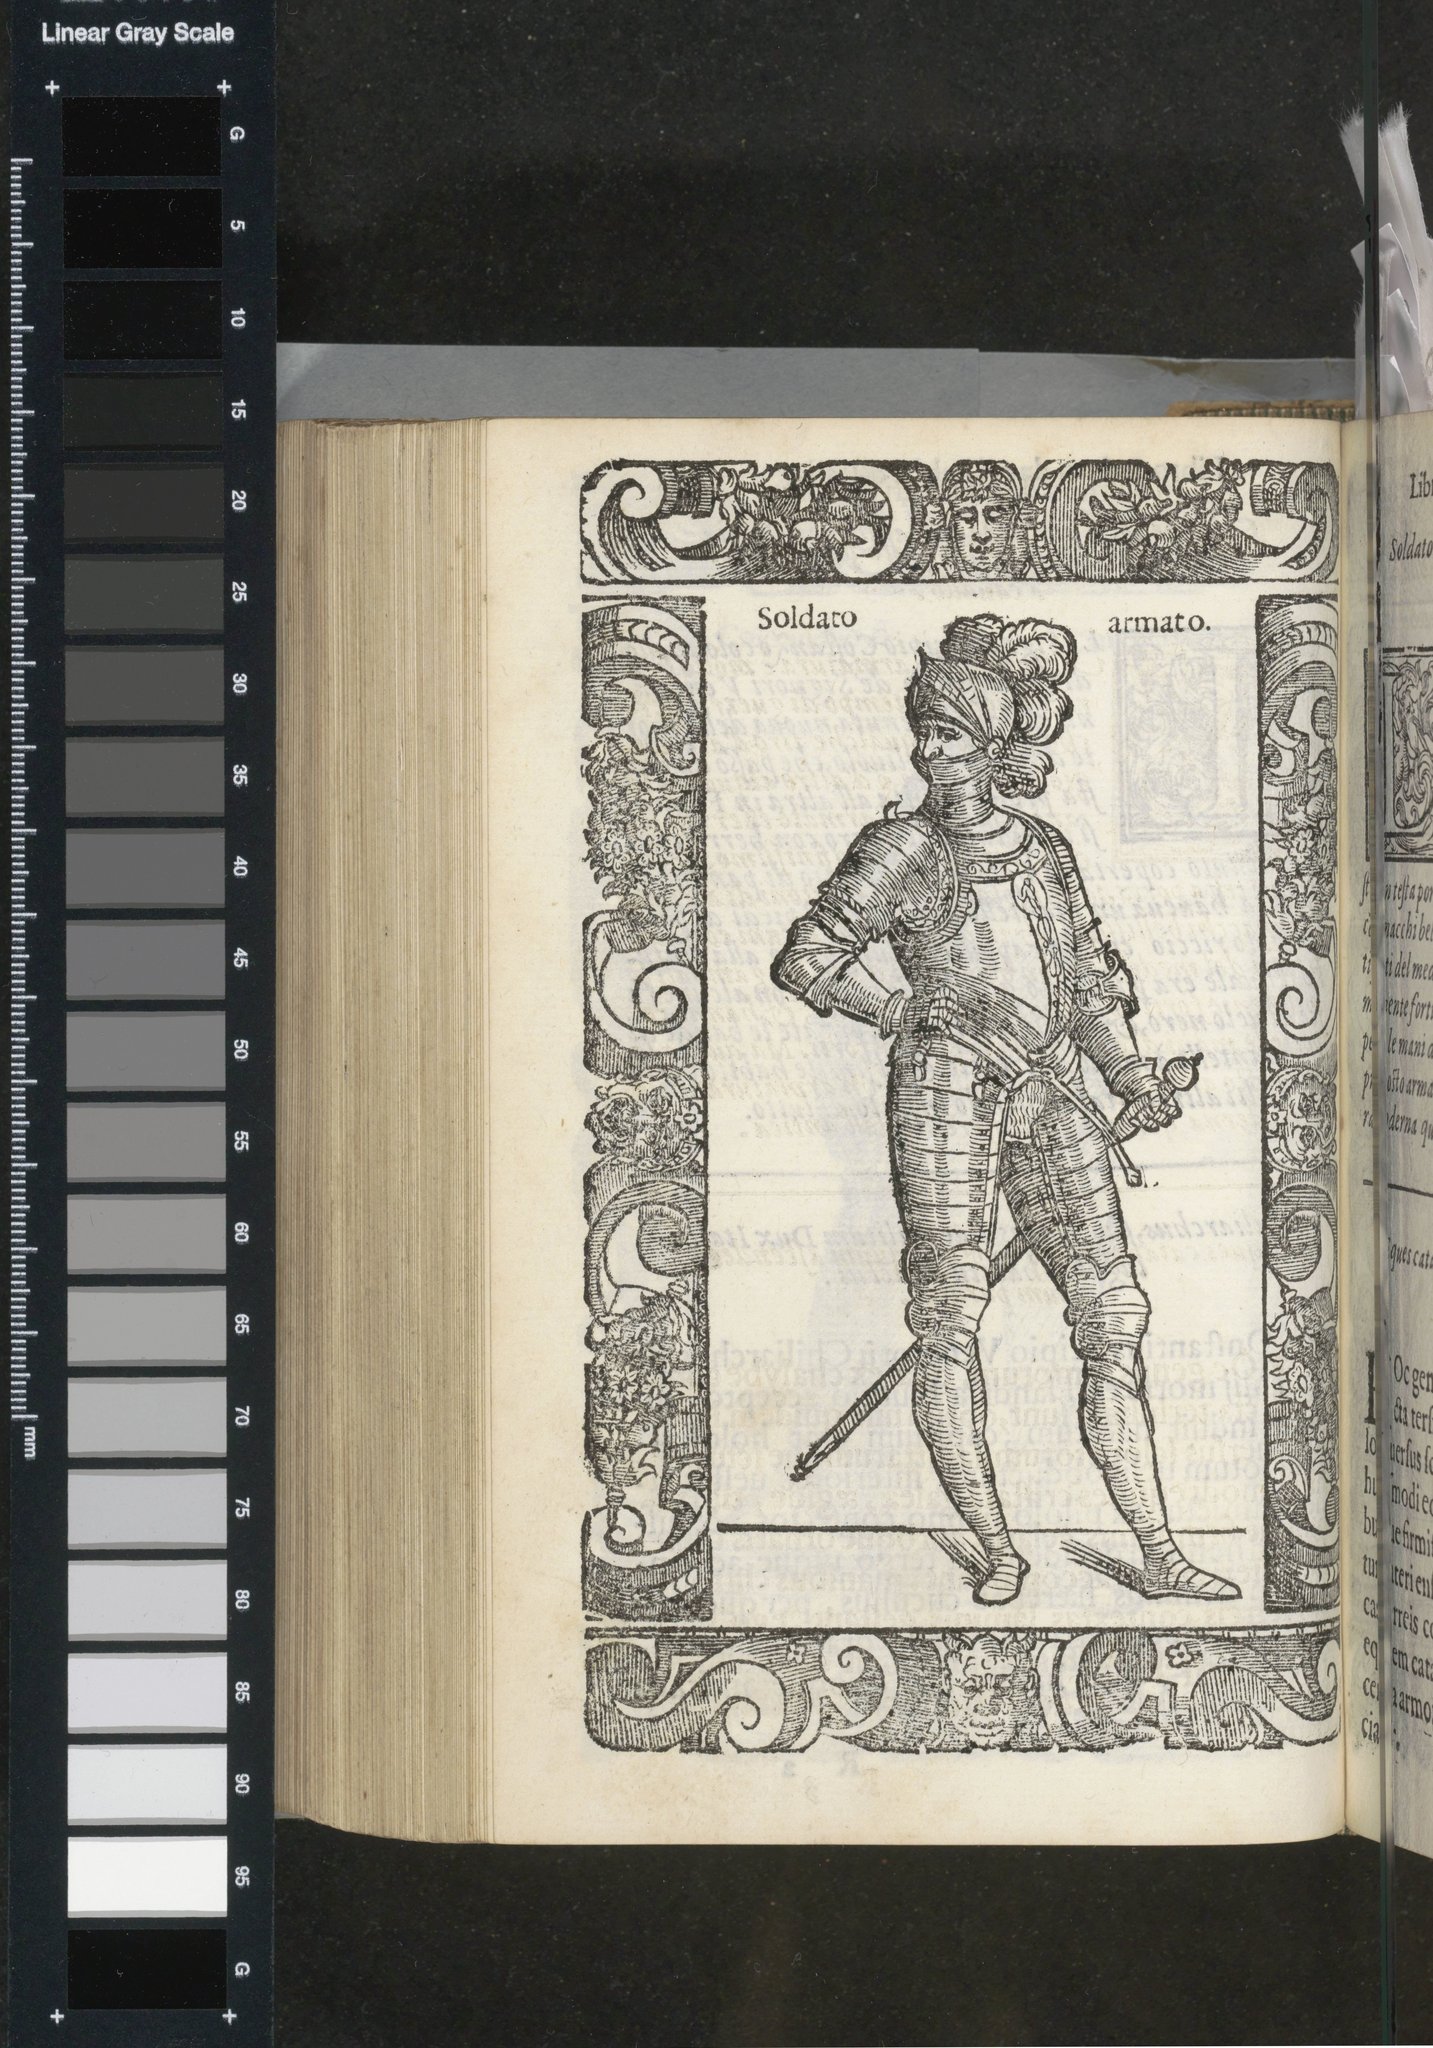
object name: costume print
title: Soldato armato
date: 1598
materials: paper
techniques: woodcut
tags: fashion plates